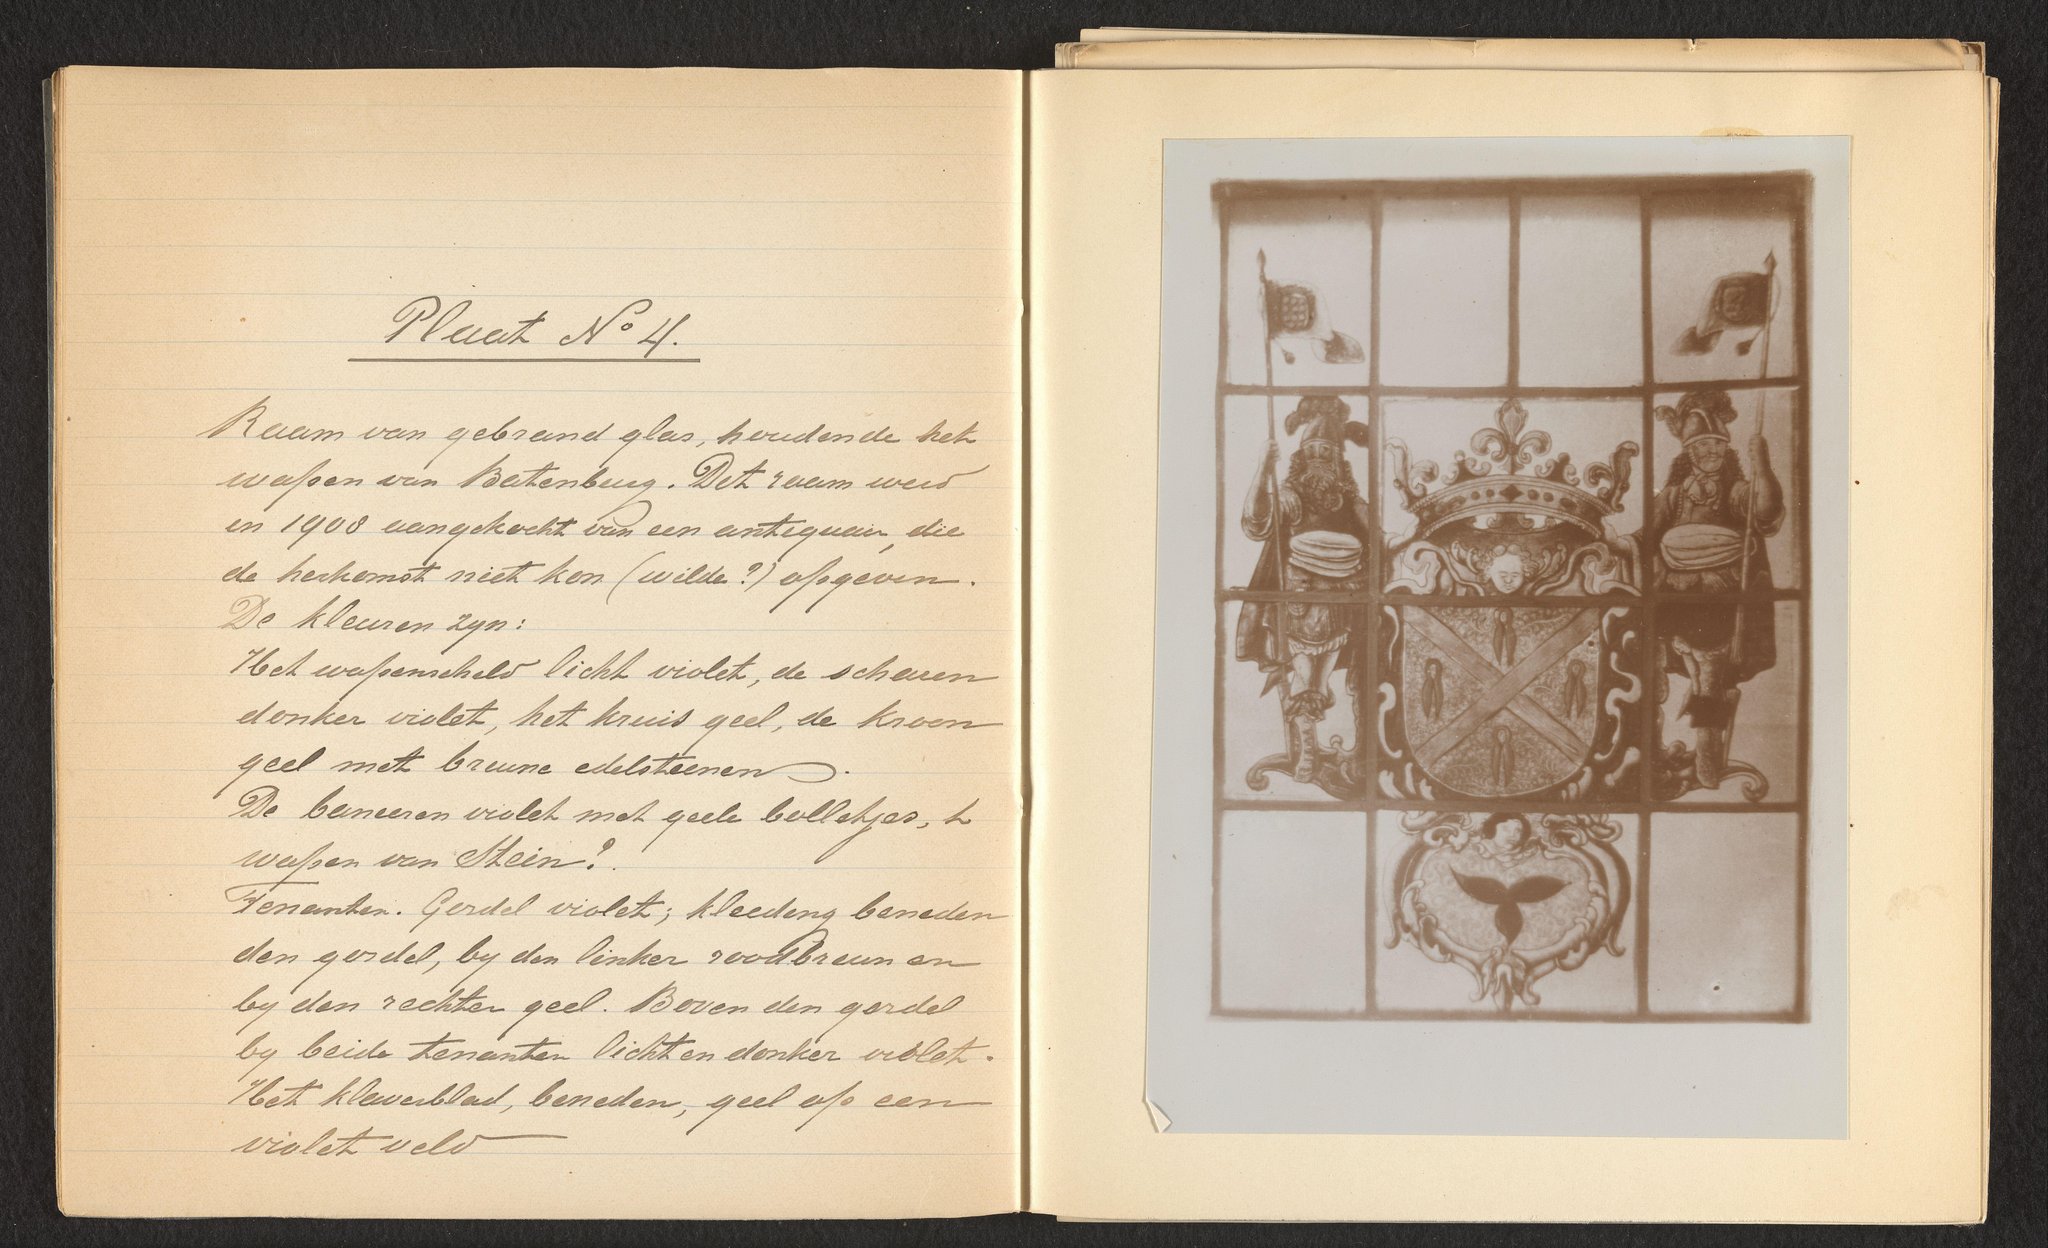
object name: photograph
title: Raam van gebrandschilderd glas met het wapen van Batenburg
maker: benjamin charlé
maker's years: 1845-1925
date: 1903-1908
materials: paper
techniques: collodion silver print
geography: batenburg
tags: armorial bearing, heraldry